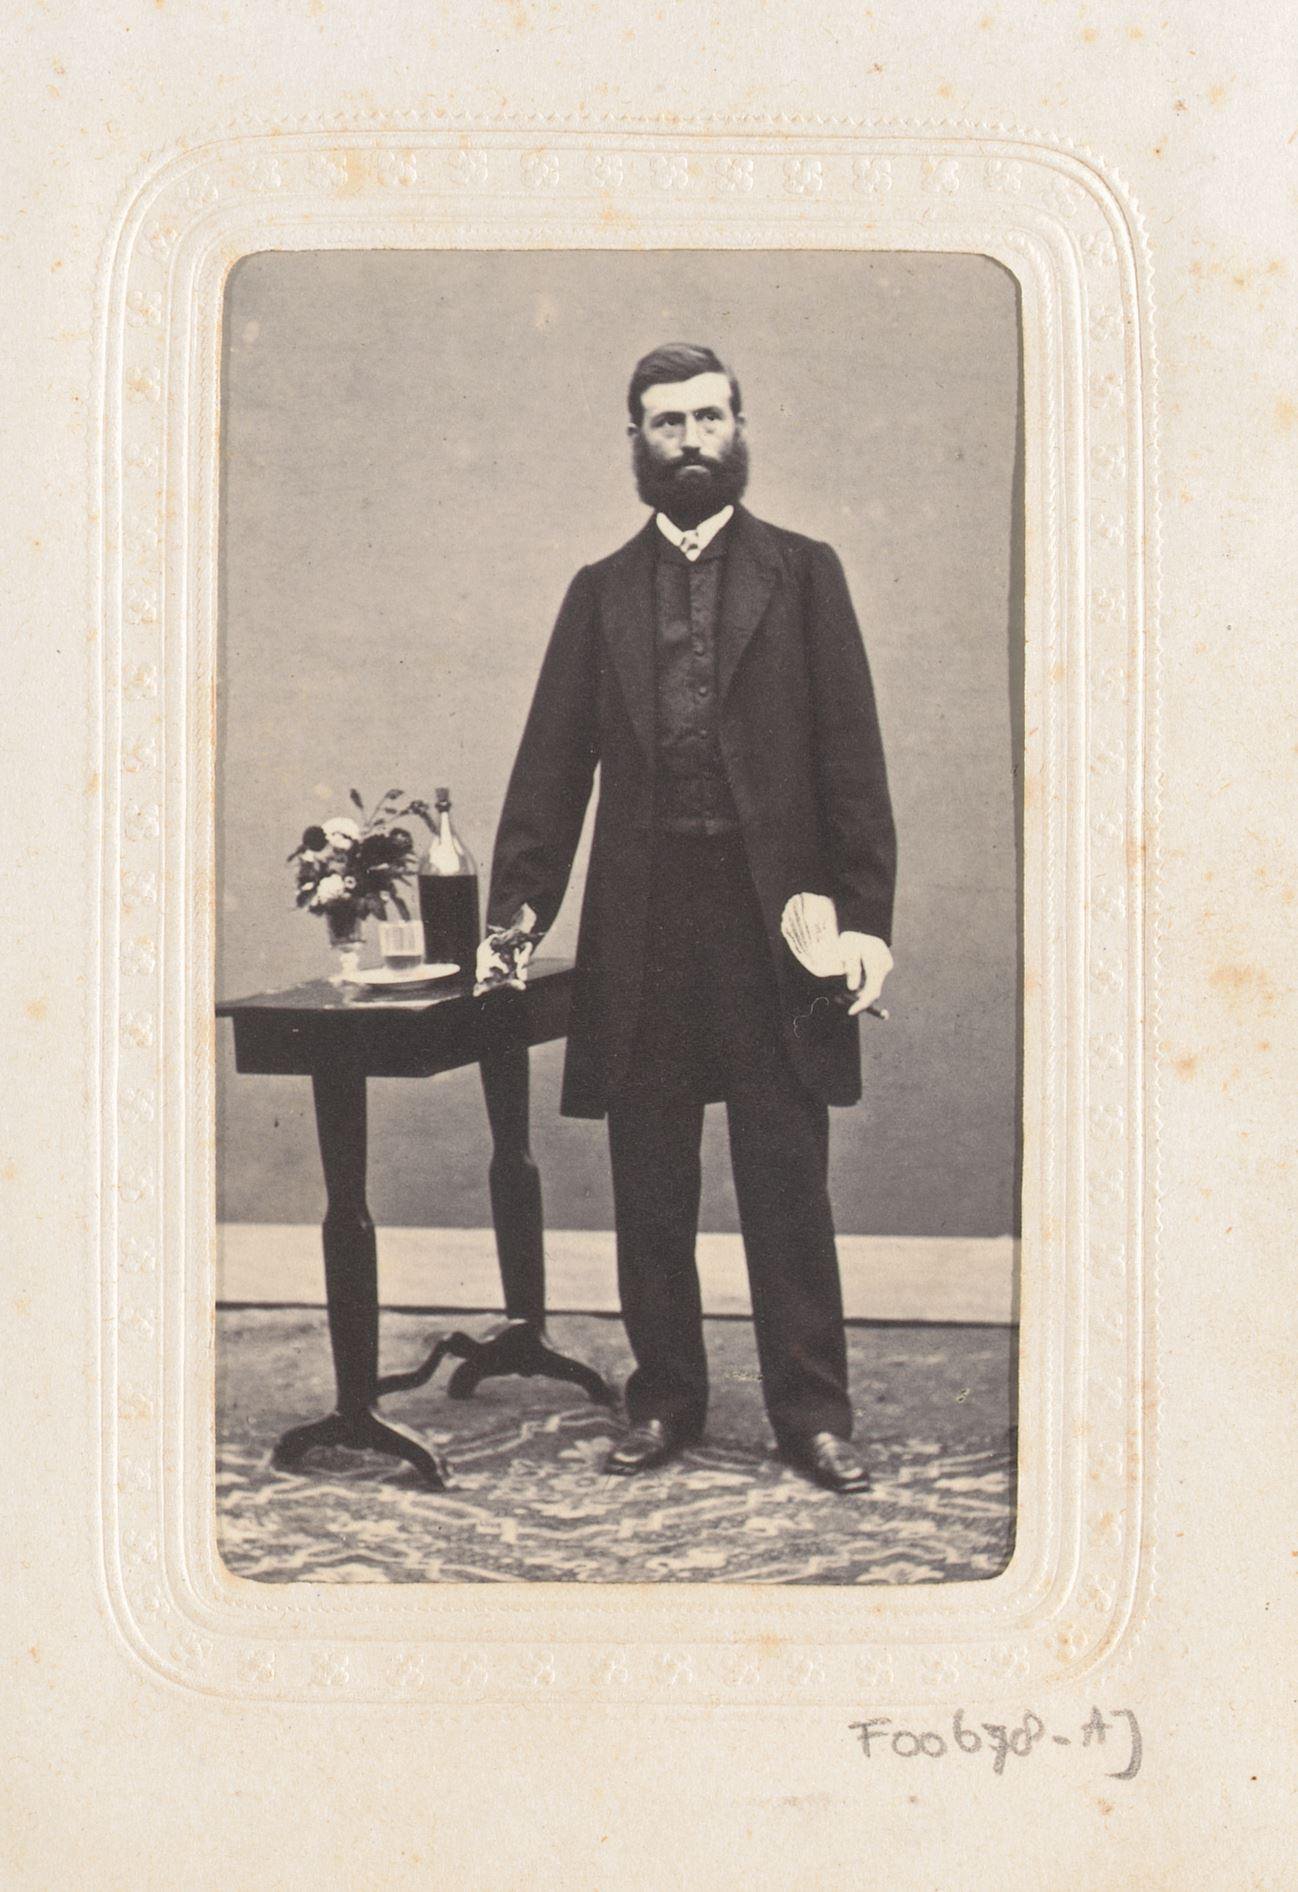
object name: album leaf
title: Portret van een staande man met kaarten, sigaar en wijn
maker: j. peukert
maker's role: fotograaf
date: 1860-1880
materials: cardboard, photographic support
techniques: albumen print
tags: cigar, historical persons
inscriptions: inscription: ‘Peukert J./ Maler & Fotograf’